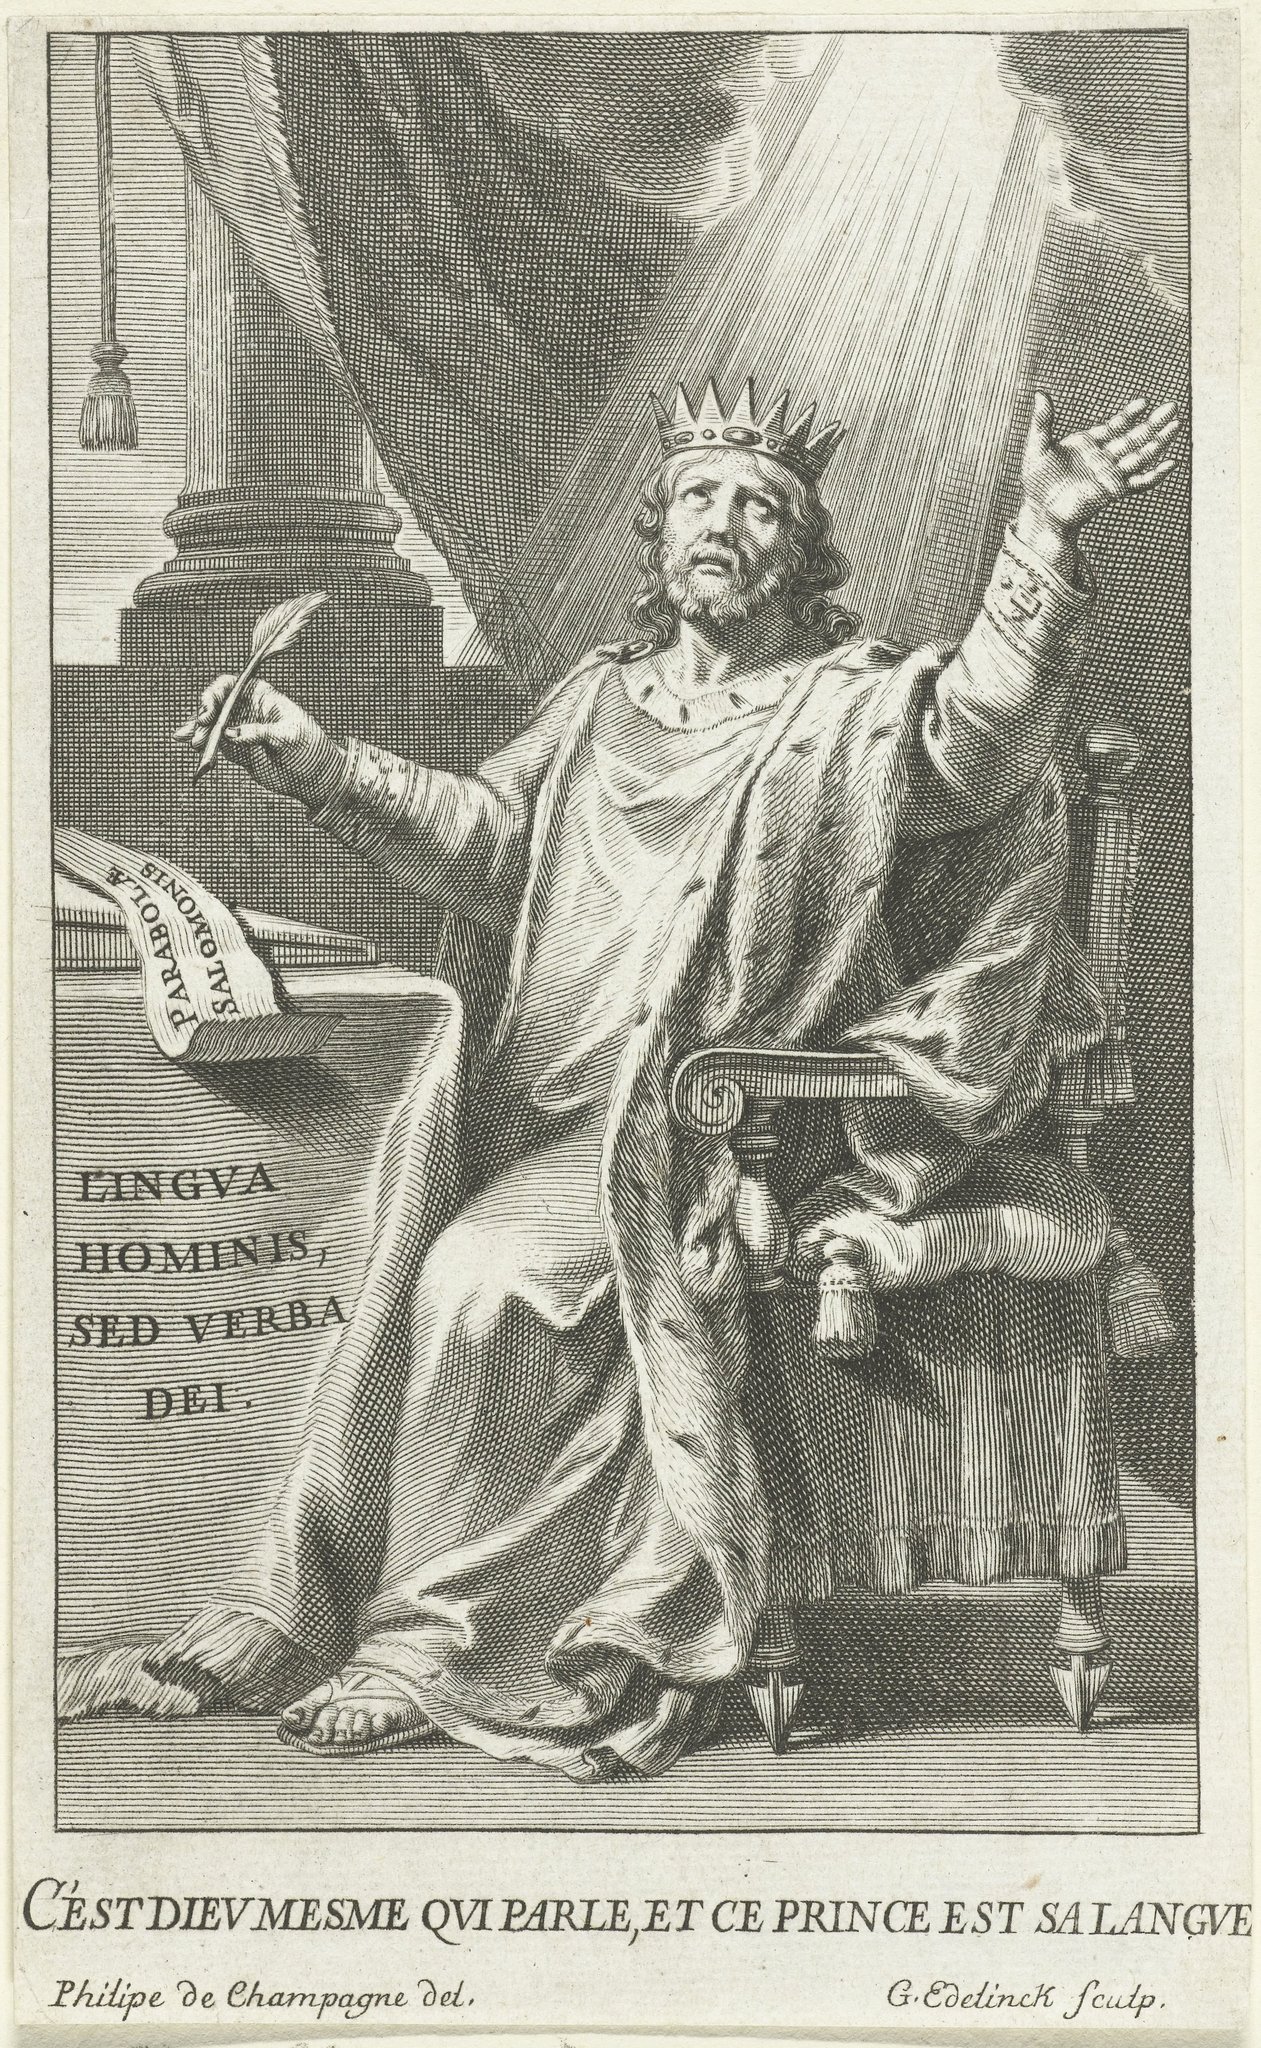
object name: print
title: Koning Salomon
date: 1666-1707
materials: paper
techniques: engraving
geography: paris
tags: solomon (not in biblical context); possible attributes of solomon: crown, sceptre, sword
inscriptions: collector's mark: Lugt 240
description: Koning Salomon zit met opgeheven arm en ganzeveer in stralen licht vanuit de hemel. onder de voostelling een onderschrift in Latijn.